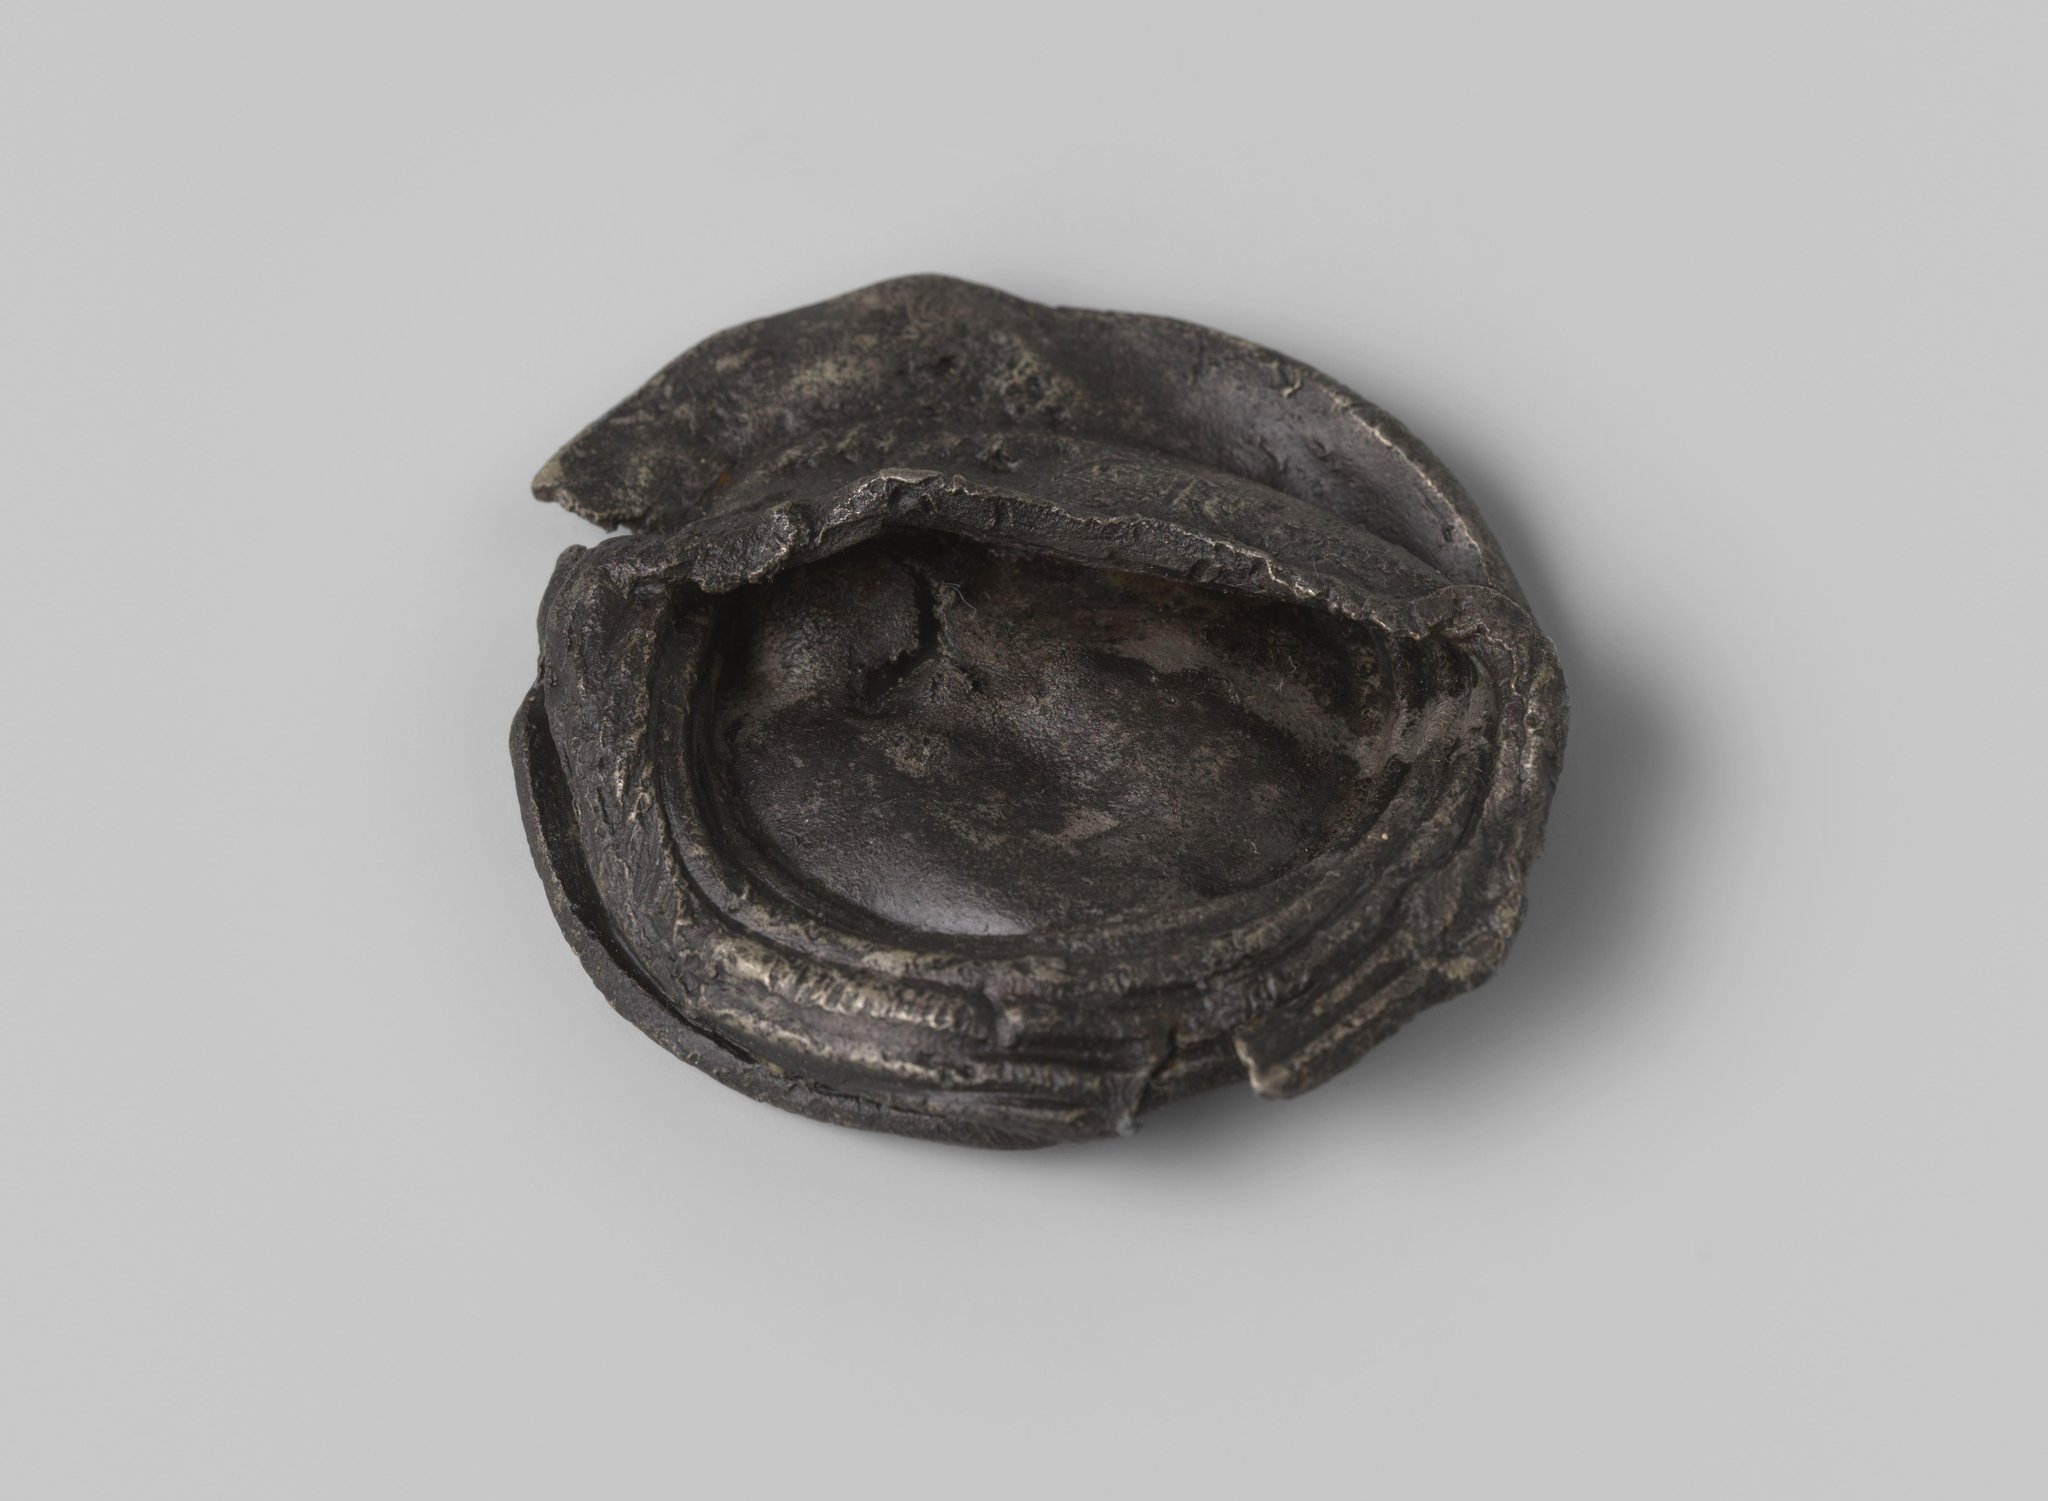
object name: screwcap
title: Schroefdop uit het wrak van de Oost-Indiëvaarder Hollandia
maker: Anonymous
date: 1700-1743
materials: tin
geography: netherlands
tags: verenigde oostindische compagnie, hollandia (schip), annet